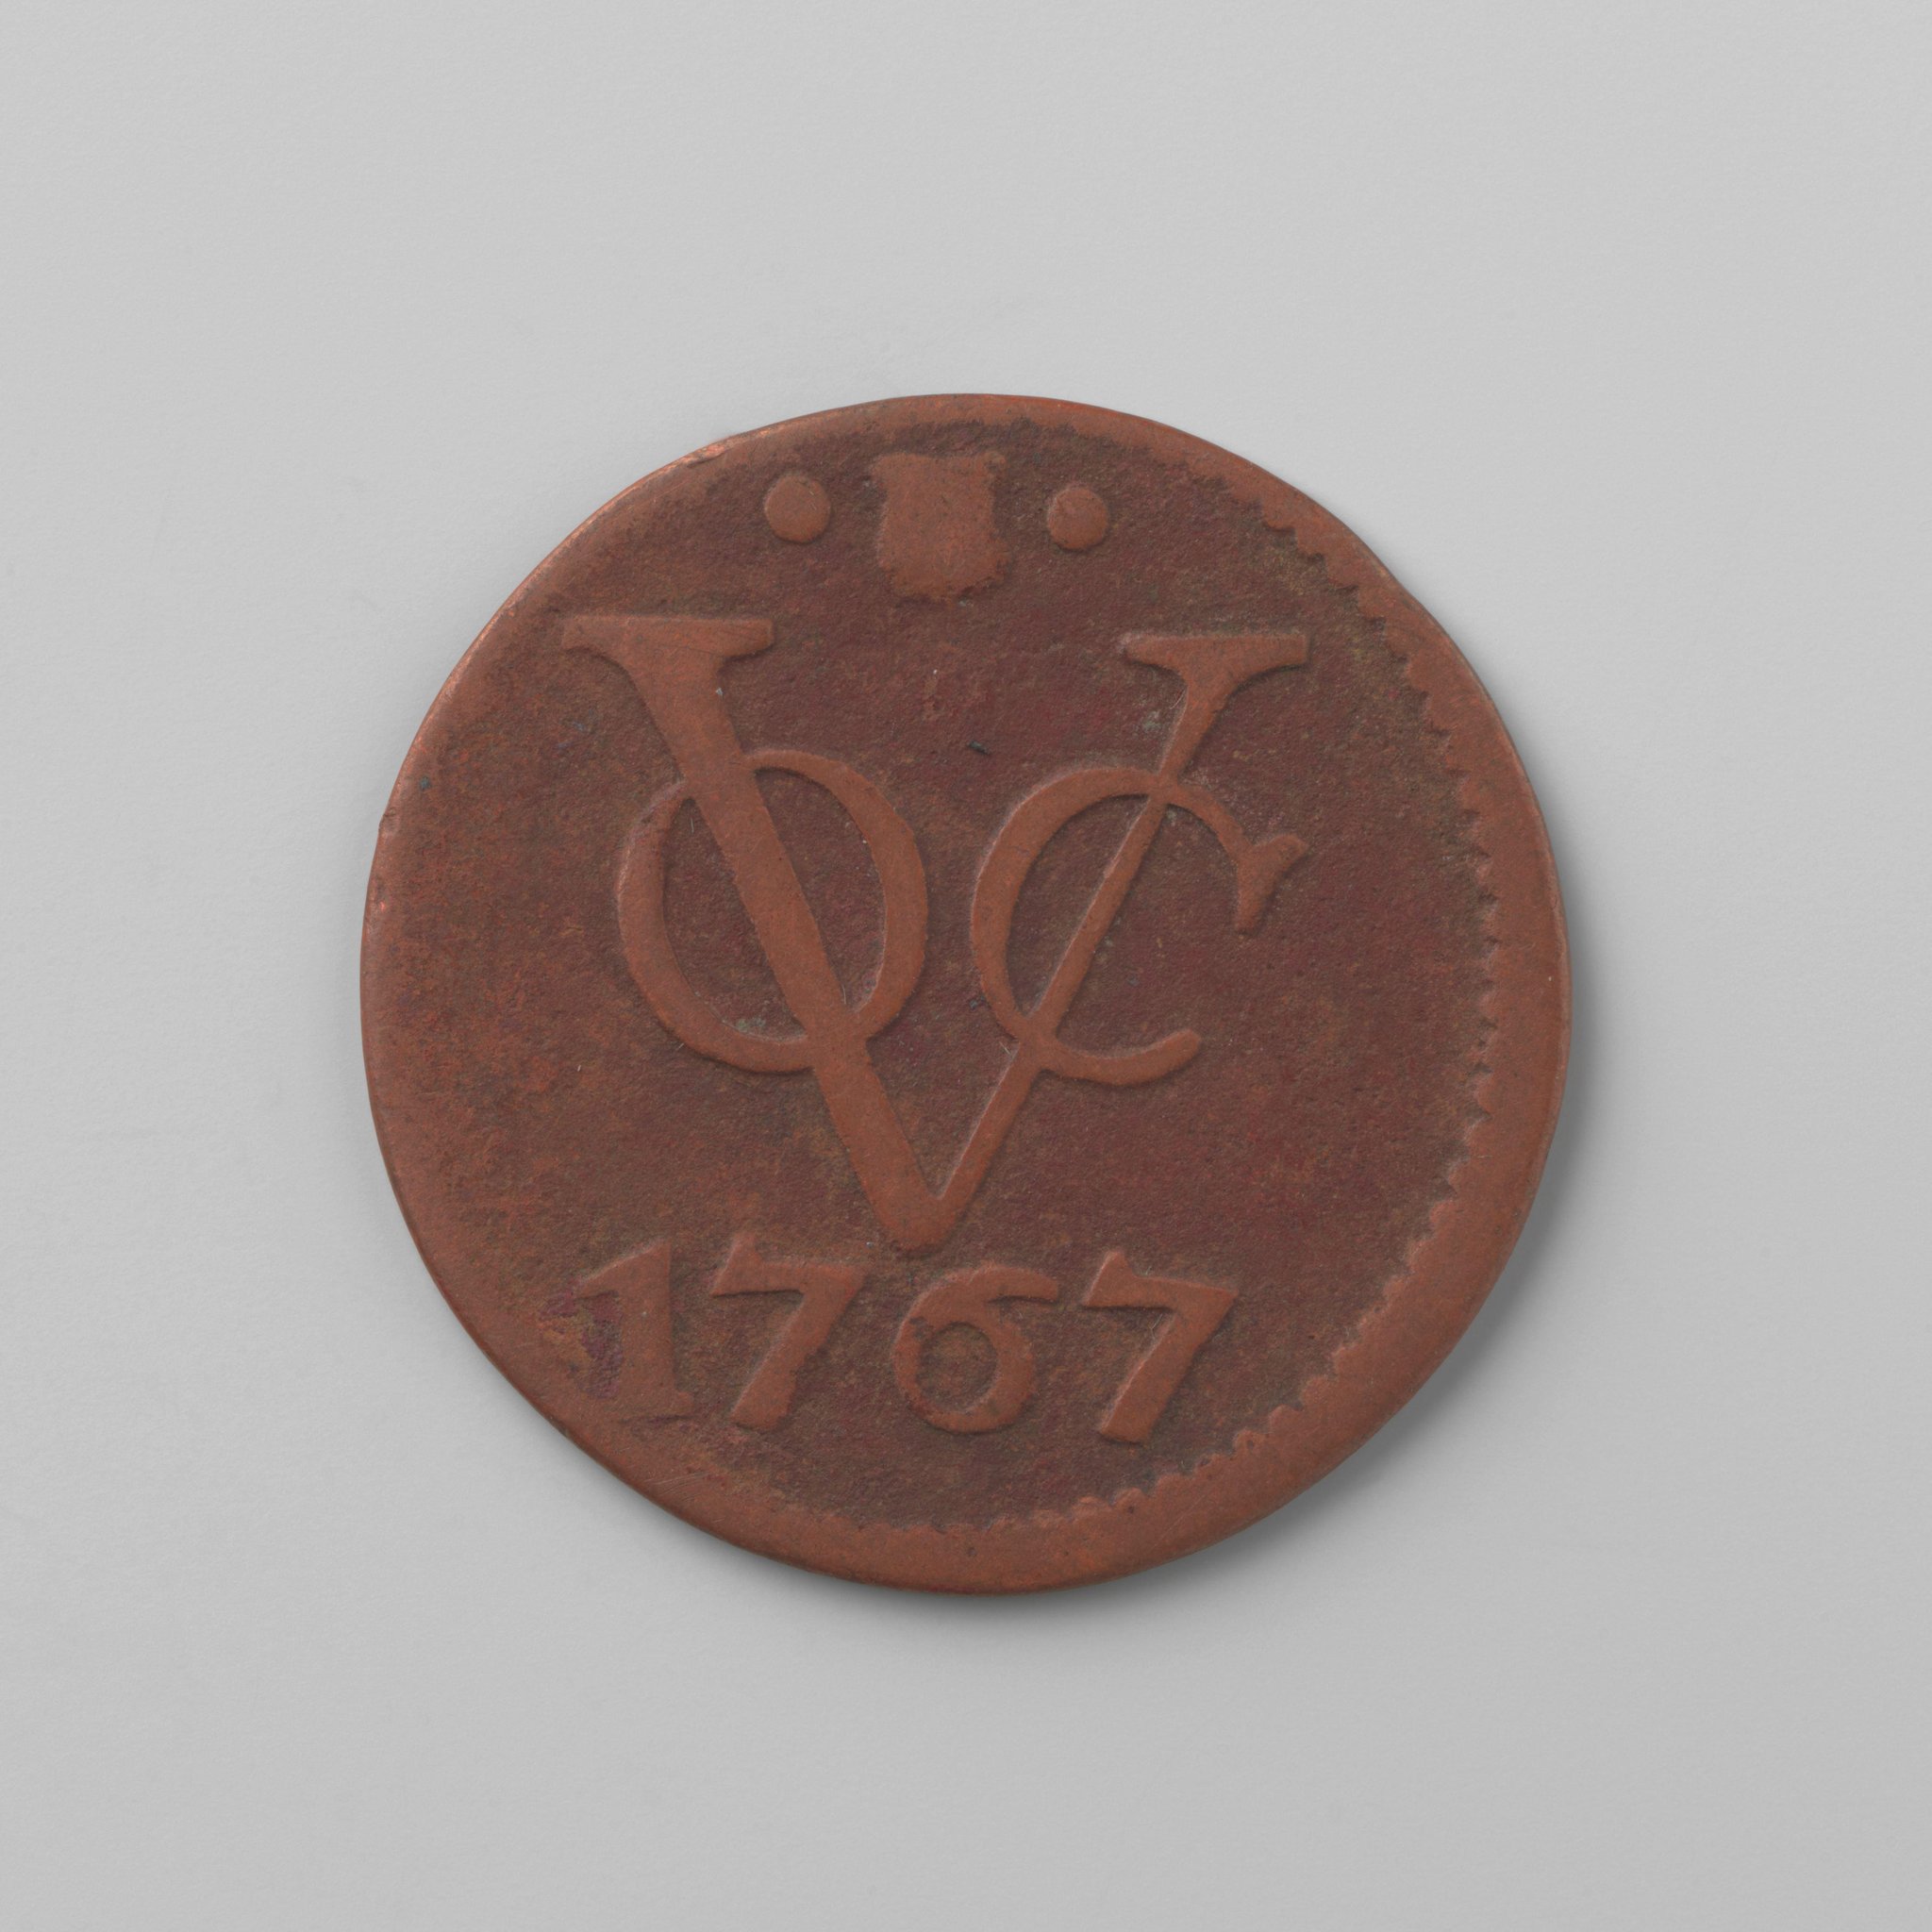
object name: coin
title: Duit van de VOC uit de stad Utrecht,1767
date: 1767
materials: copper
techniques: striking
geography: utrecht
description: Koperen munt. Voorzijde: op balk, waaronder guirlande, geplaatst, door twee leeuwen gehouden gekroond wapenschild van de stad Utrecht. Keerzijde: monogram van de VOC, waarboven muntteken en waaronder jaartal. Gladde rand.